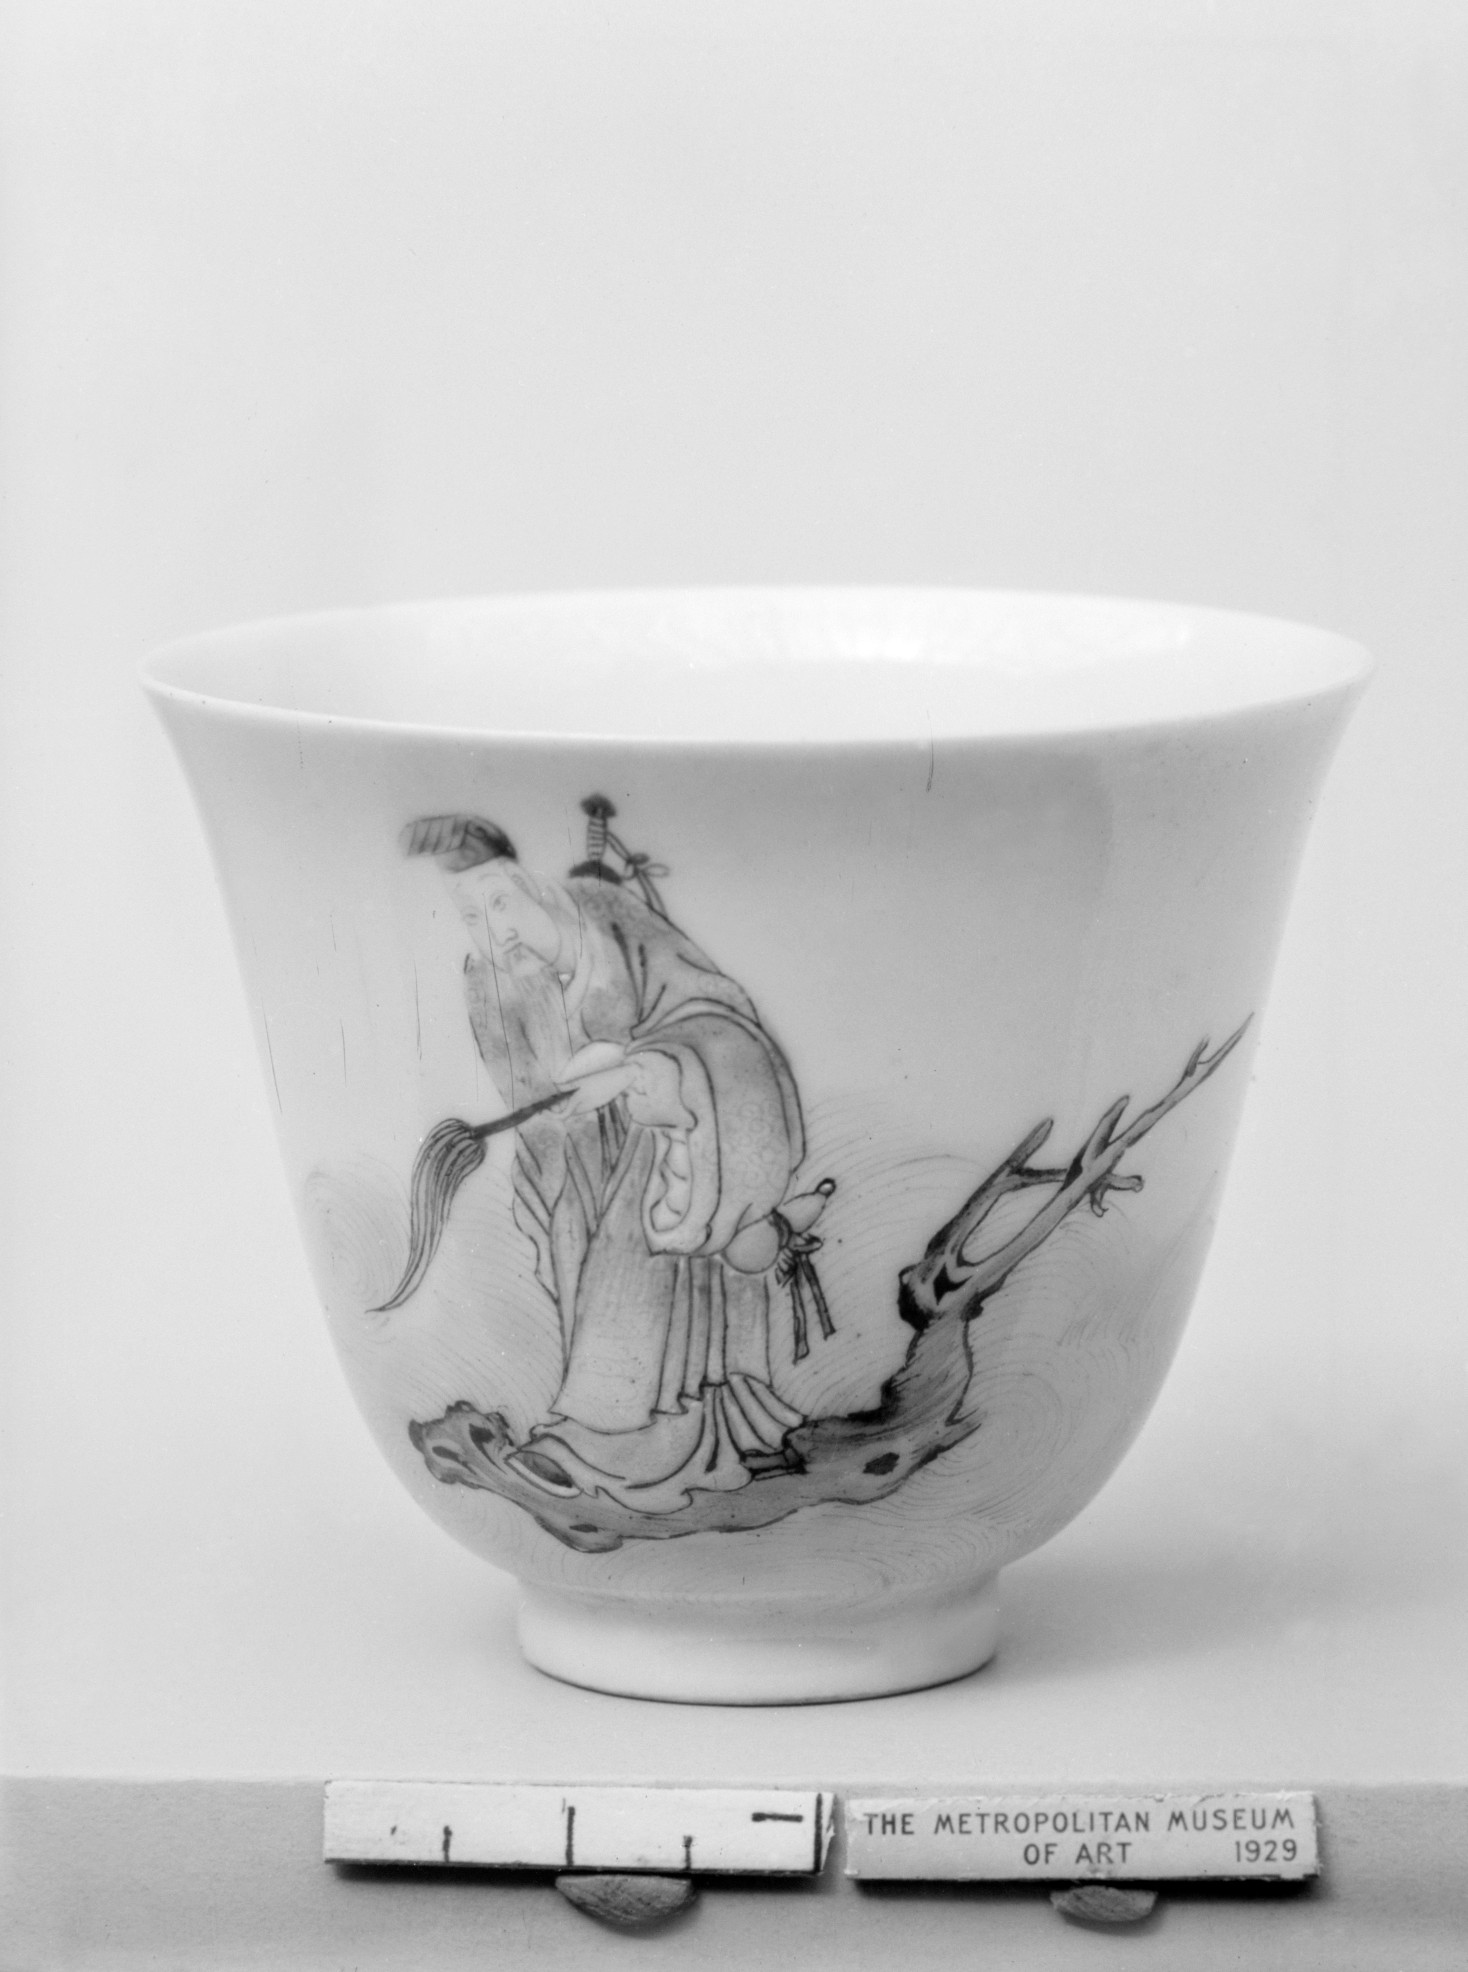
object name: cup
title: Cup with Lü Dongbin (one of the Eight Immortals)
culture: chinese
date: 1767-1833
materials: enamel, porcelain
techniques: overglaze, painting, polychrome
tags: men